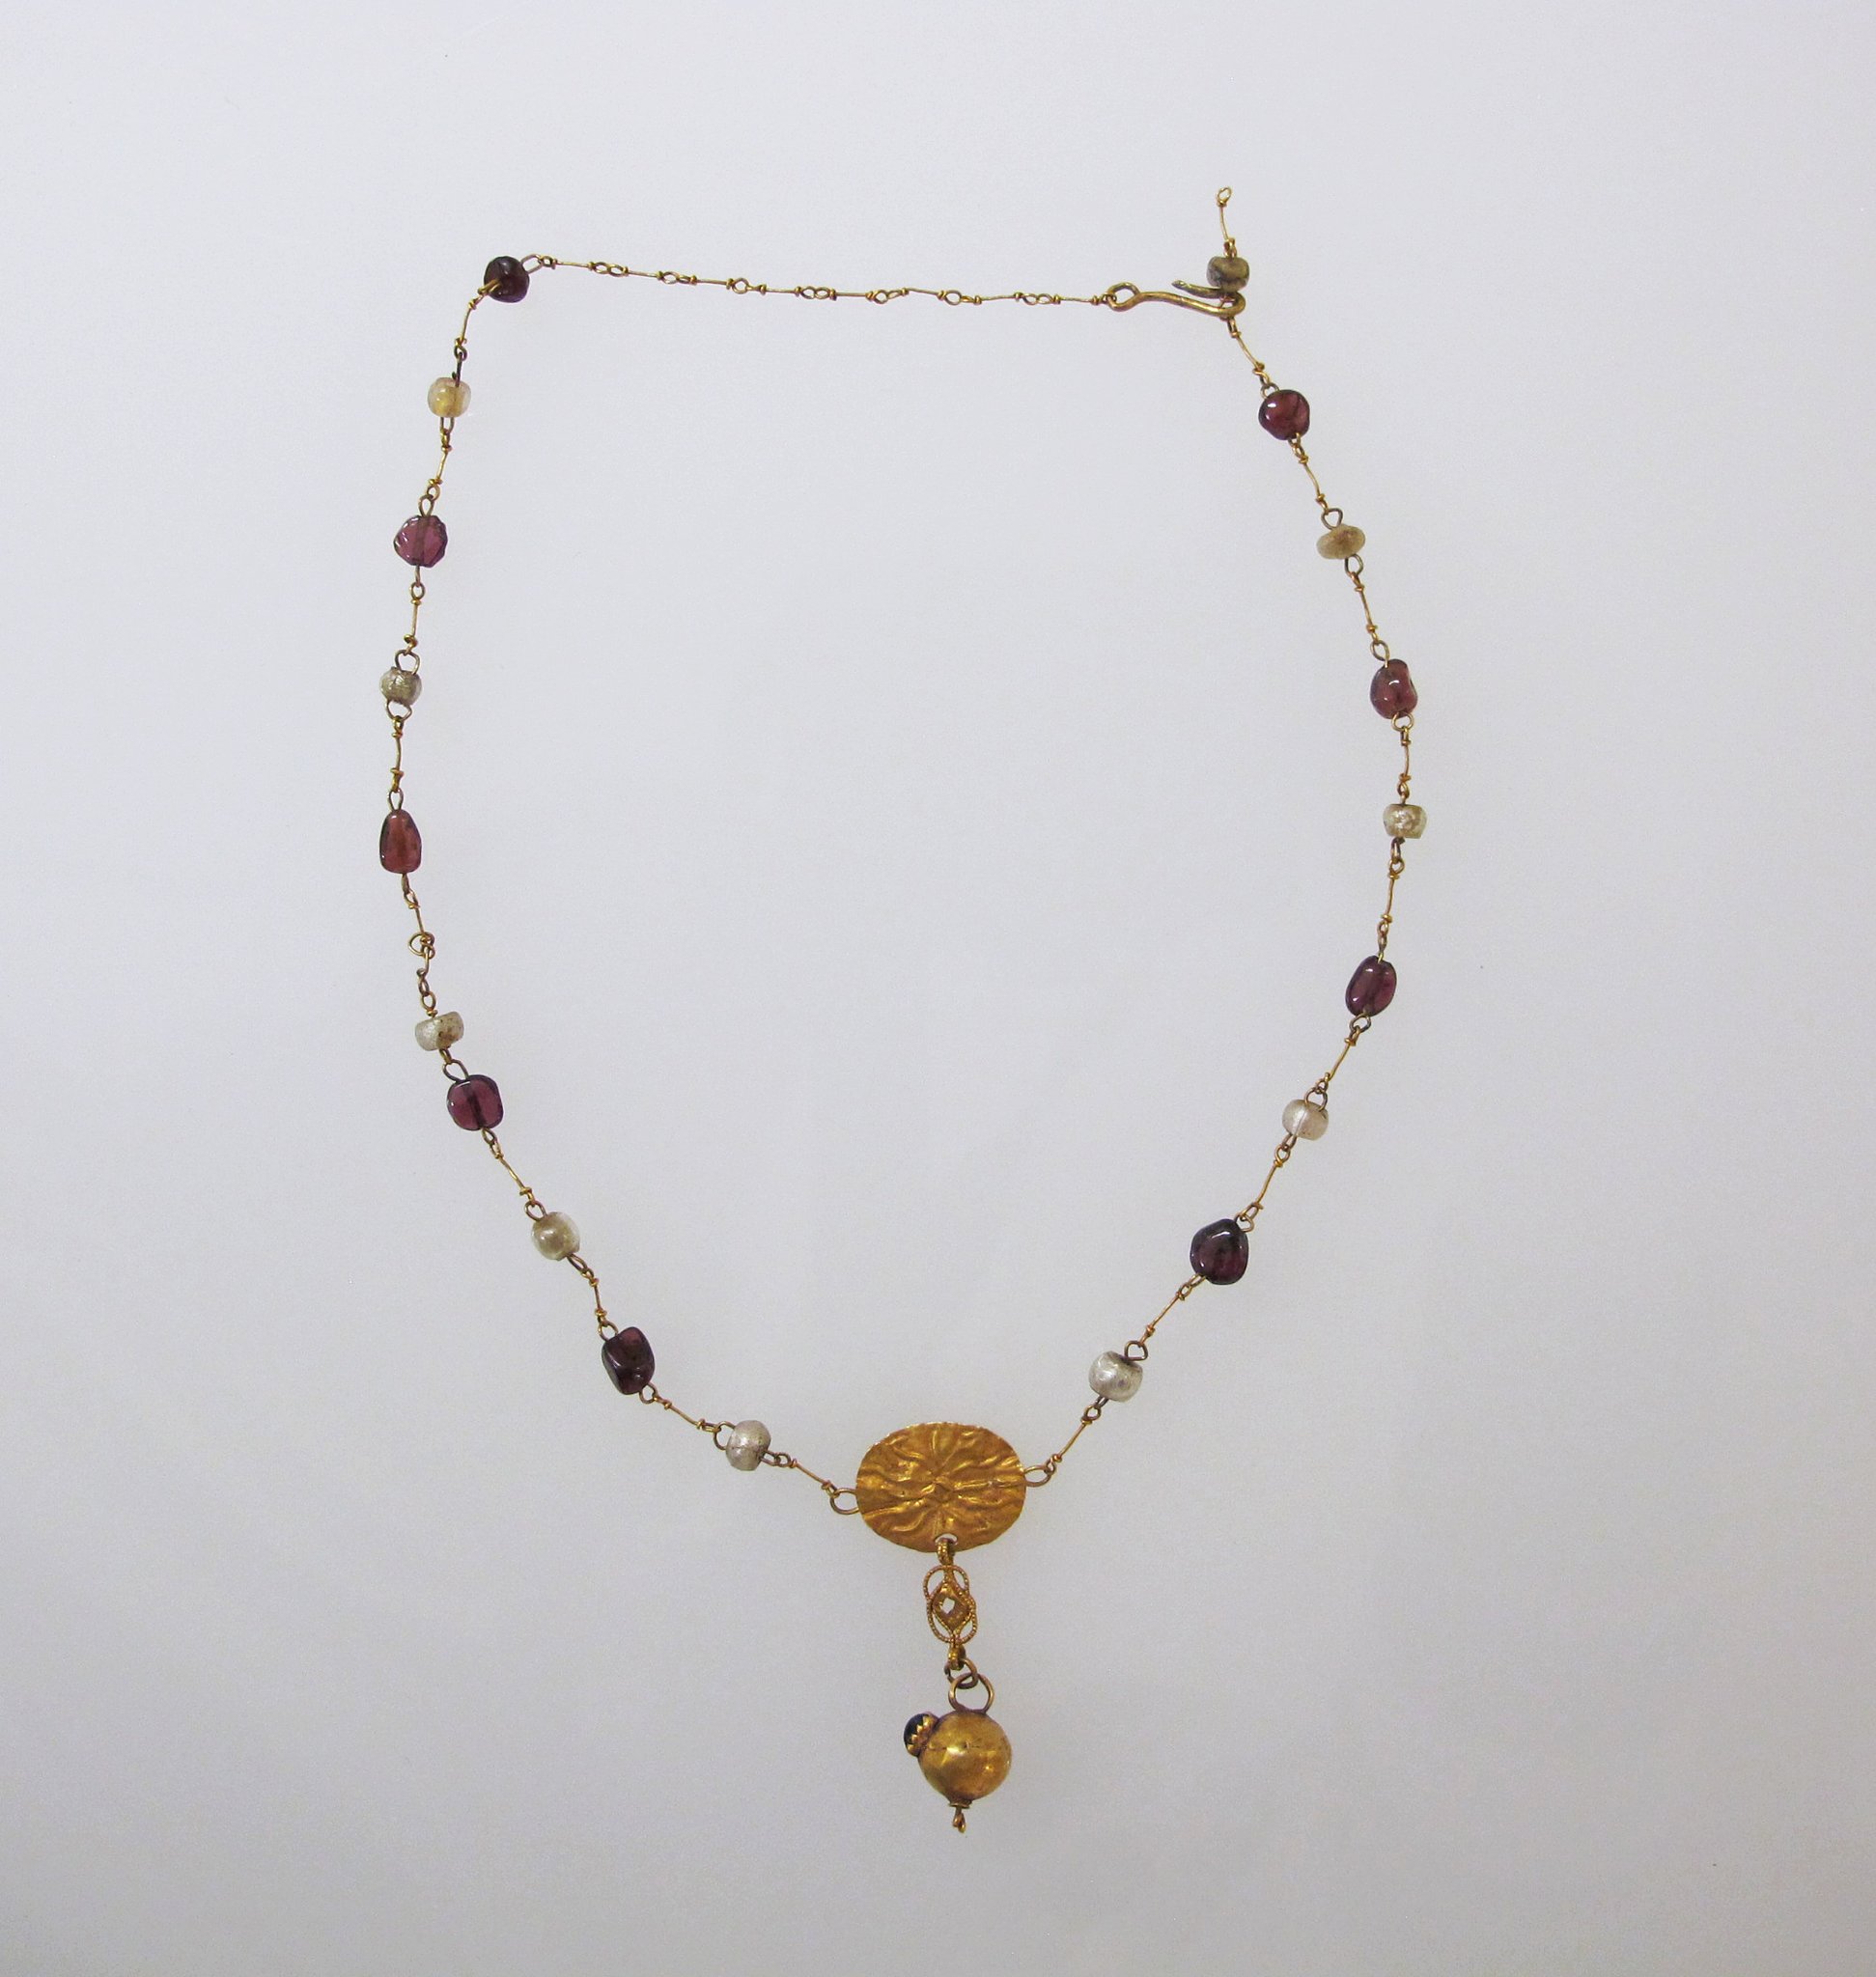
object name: pendant jewelry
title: Necklace with pendant and glass beads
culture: roman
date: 100 BCE-200 CE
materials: glass, gold, paste